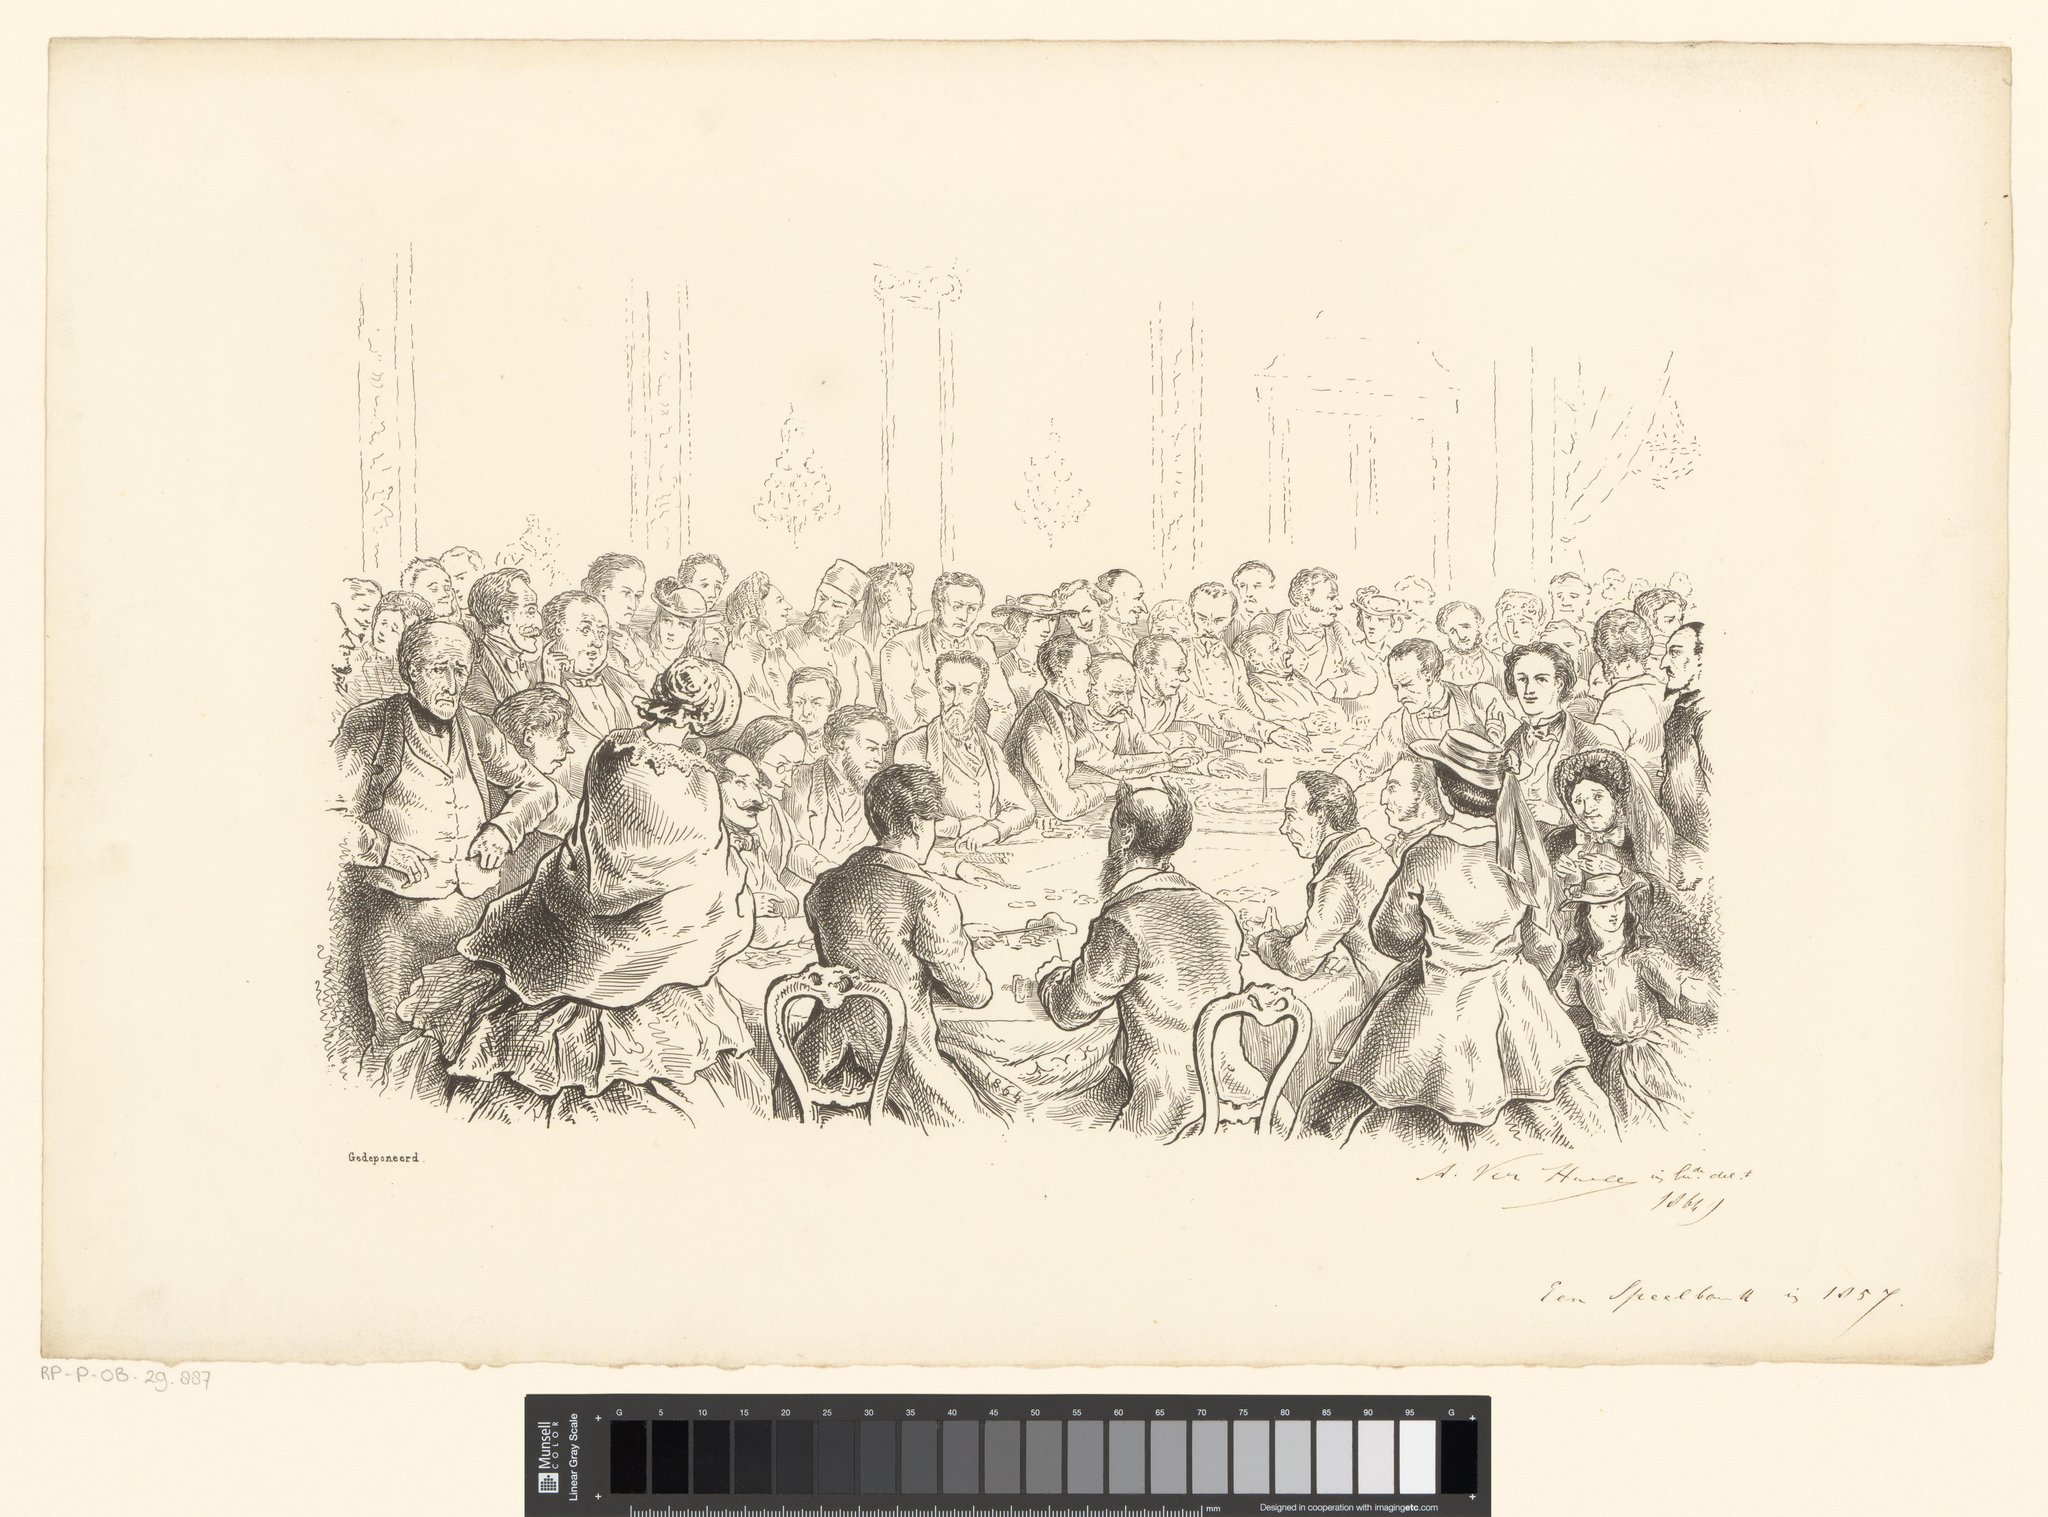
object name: print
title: Mensen rondom een speeltafel in een casino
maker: alexander ver huell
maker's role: draughtsman, print maker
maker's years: 1822-1897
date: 1864-1866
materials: paper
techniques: lithograph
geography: arnhem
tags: casino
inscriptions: : ‘Gedeponeerd.’, collector's mark: Lugt 2228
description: Een groep mannen zit rondom een speeltafel met in het midden een roulette. Omstanders kijken toe.